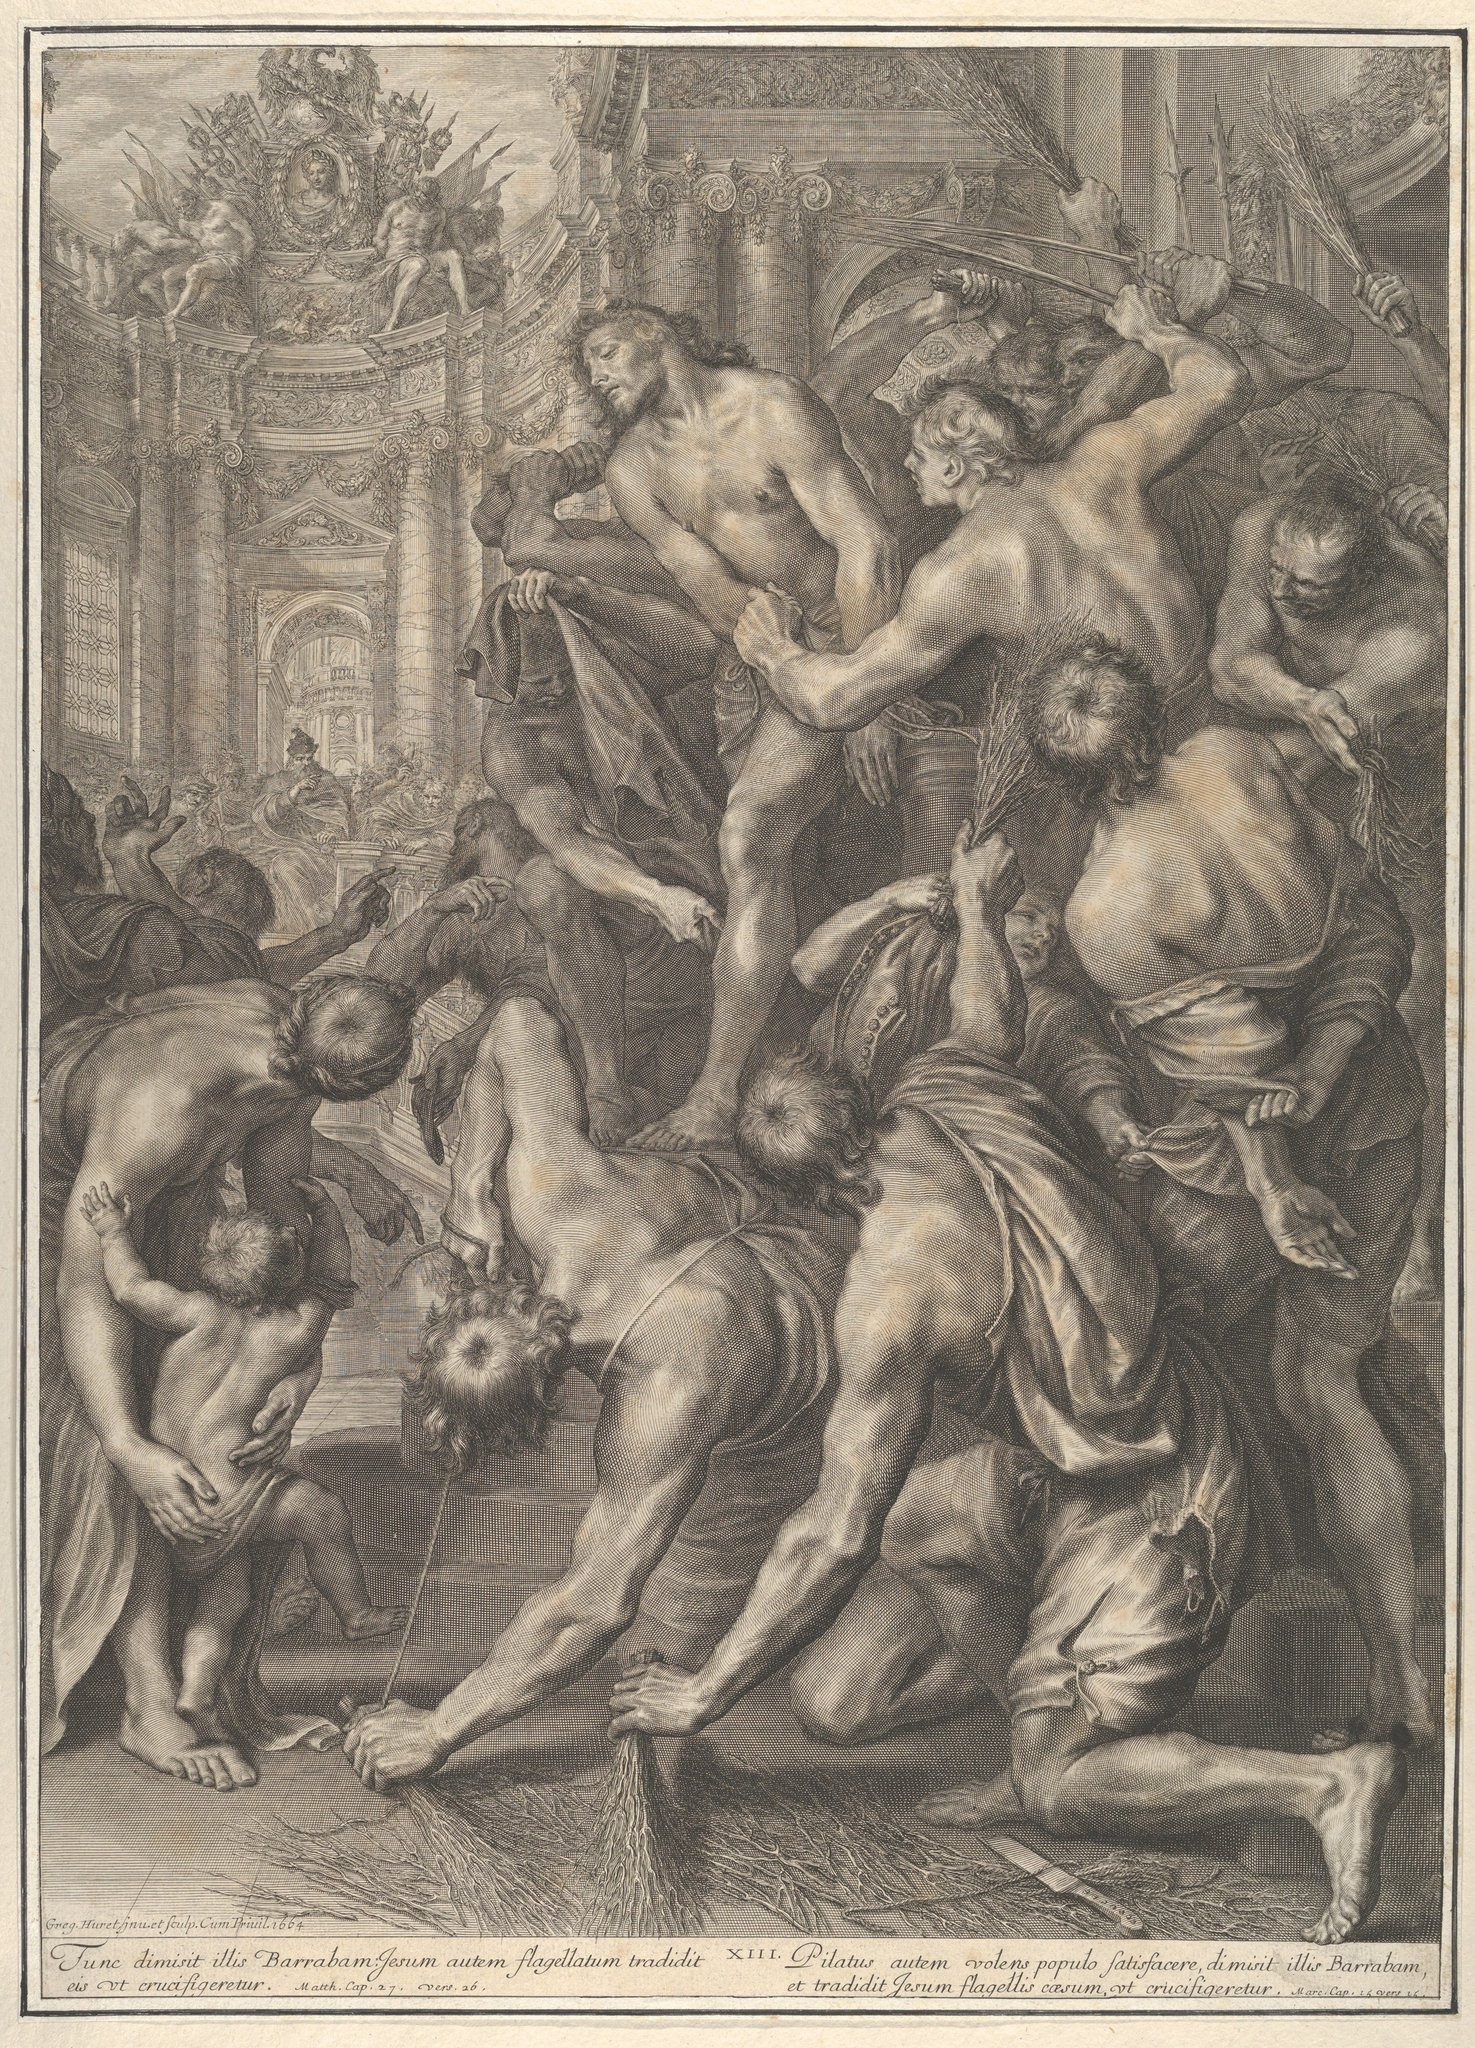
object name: print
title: The Flagellation, from The Passion of Christ, plate 13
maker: grégoire huret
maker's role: artist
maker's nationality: french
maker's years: 1606-1670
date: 1664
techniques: engraving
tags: men,christ